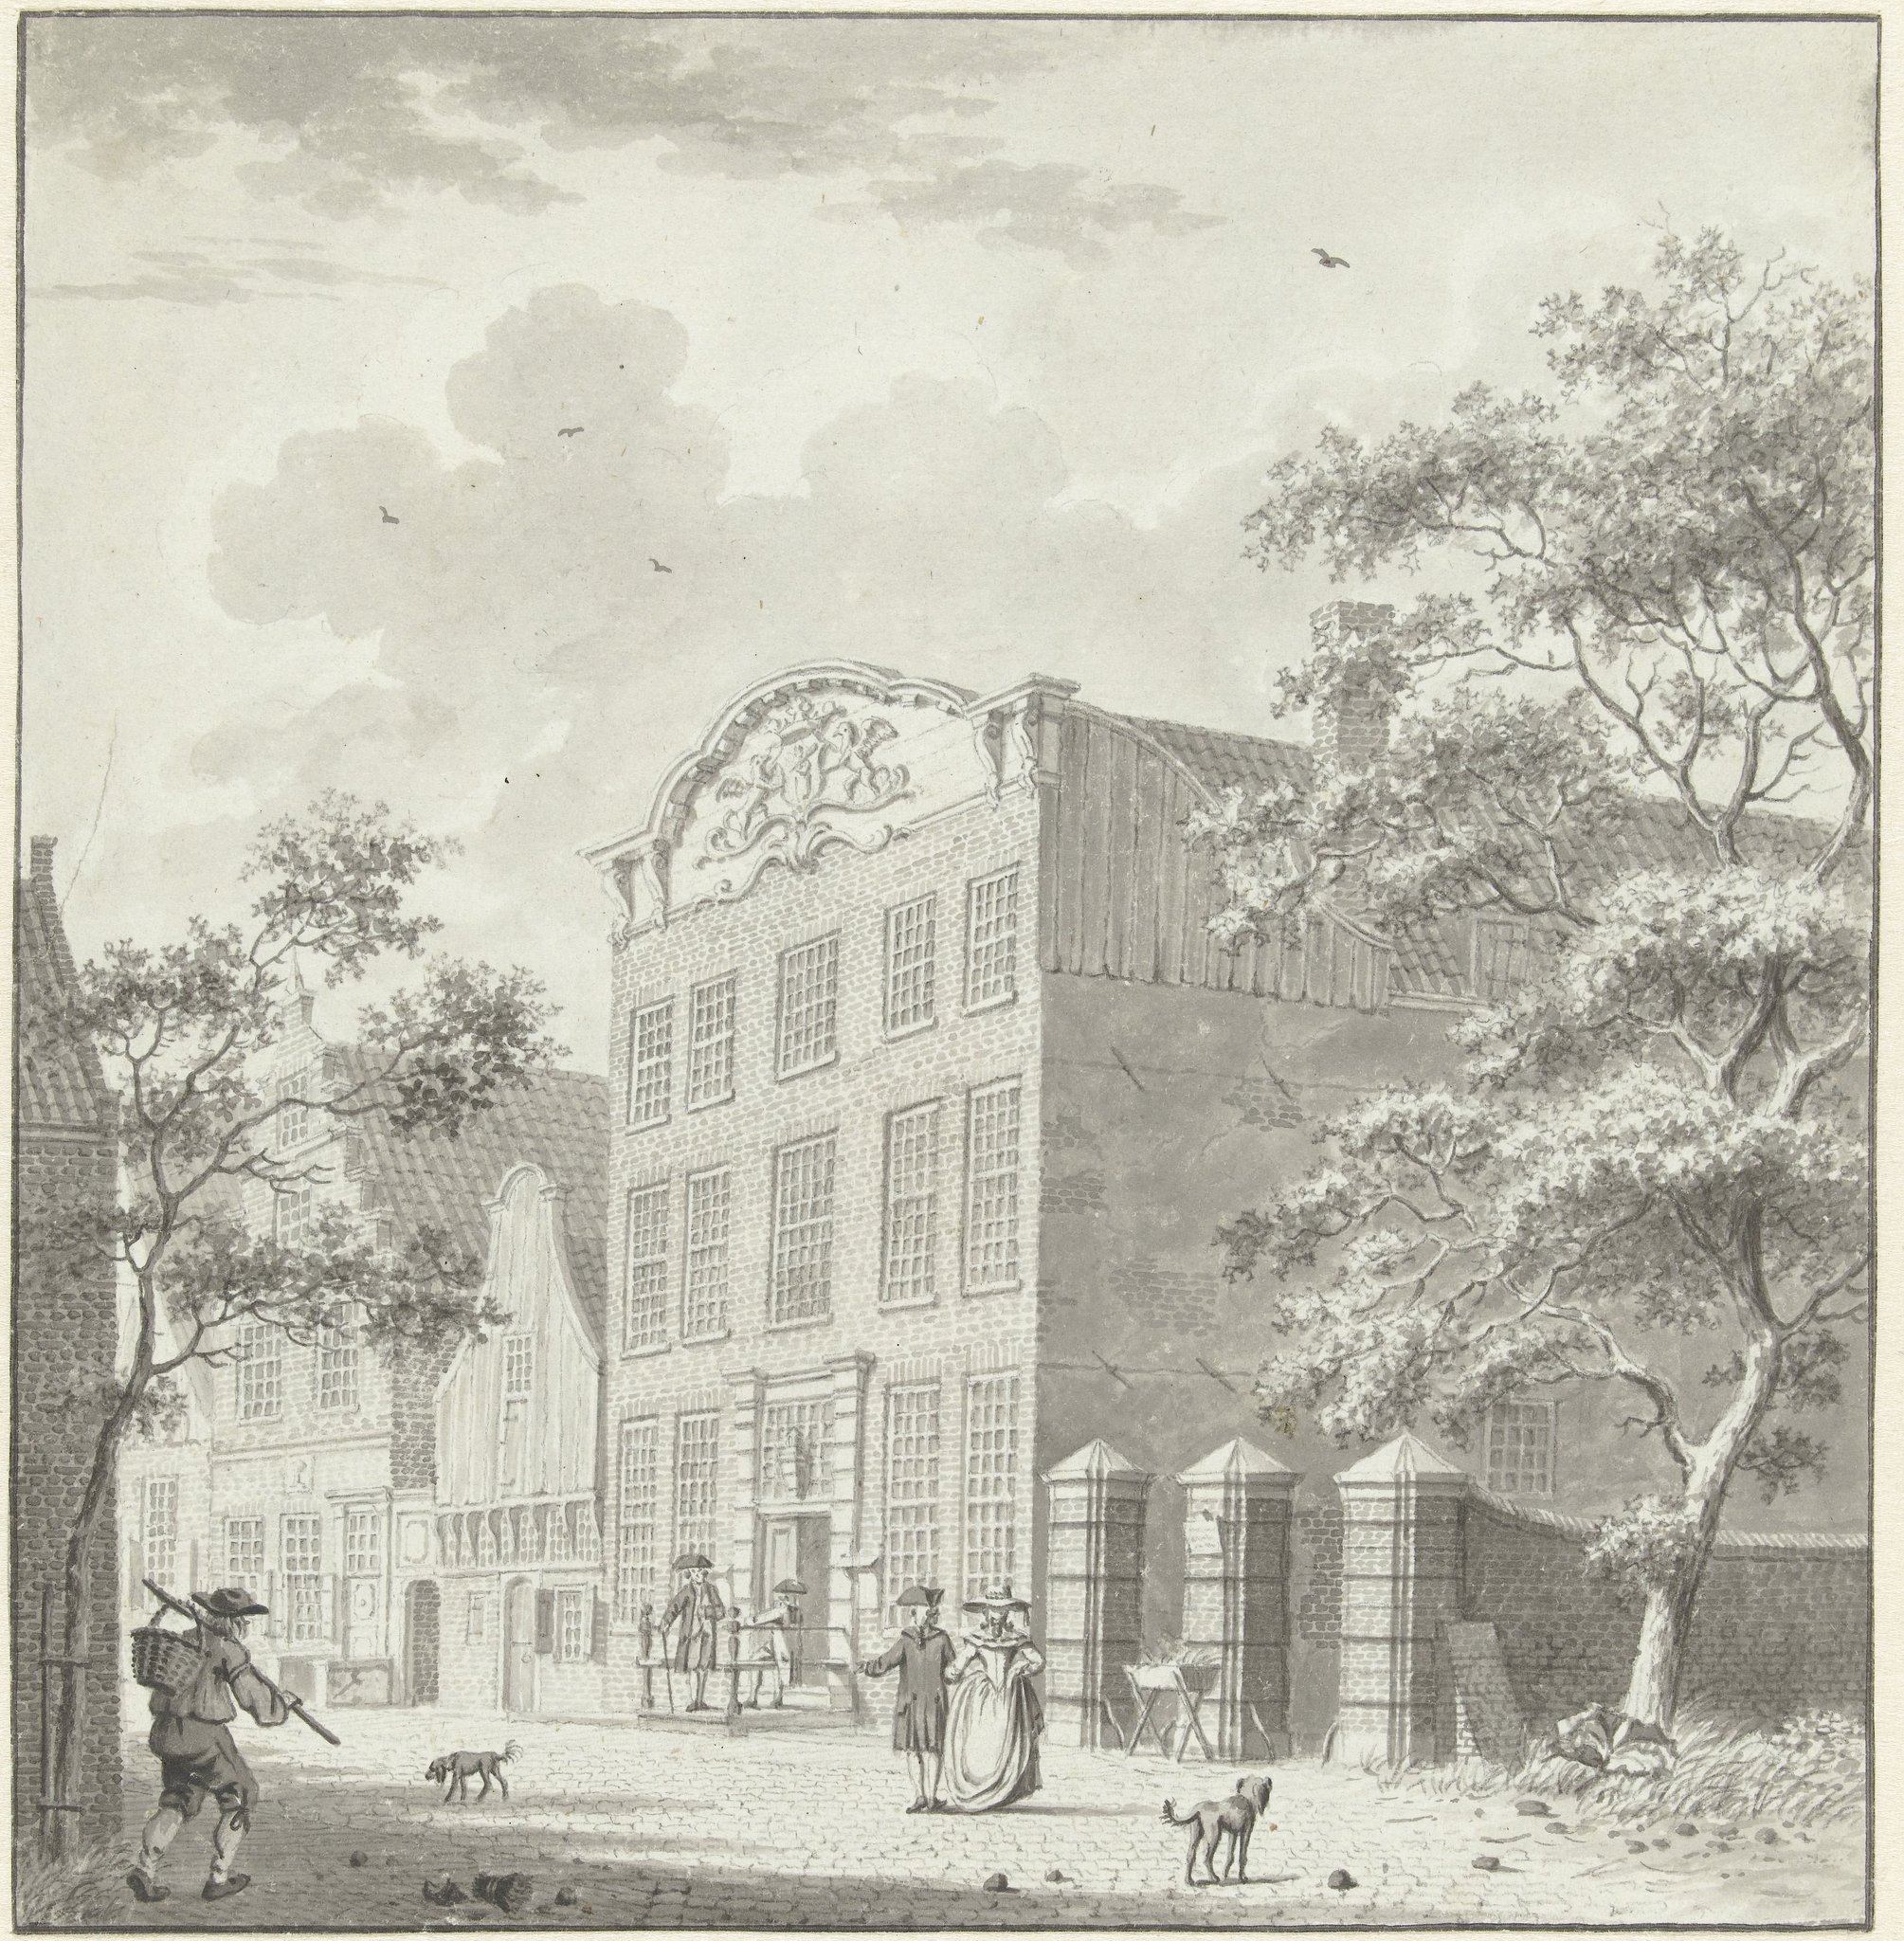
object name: drawing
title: De Doelen te Monnikendam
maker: isaac ouwater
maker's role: draughtsman, painter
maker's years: 1748-1793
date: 1758-1793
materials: chalk, ink, paper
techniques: brush, pen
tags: city-view, and landscape with man-made constructions